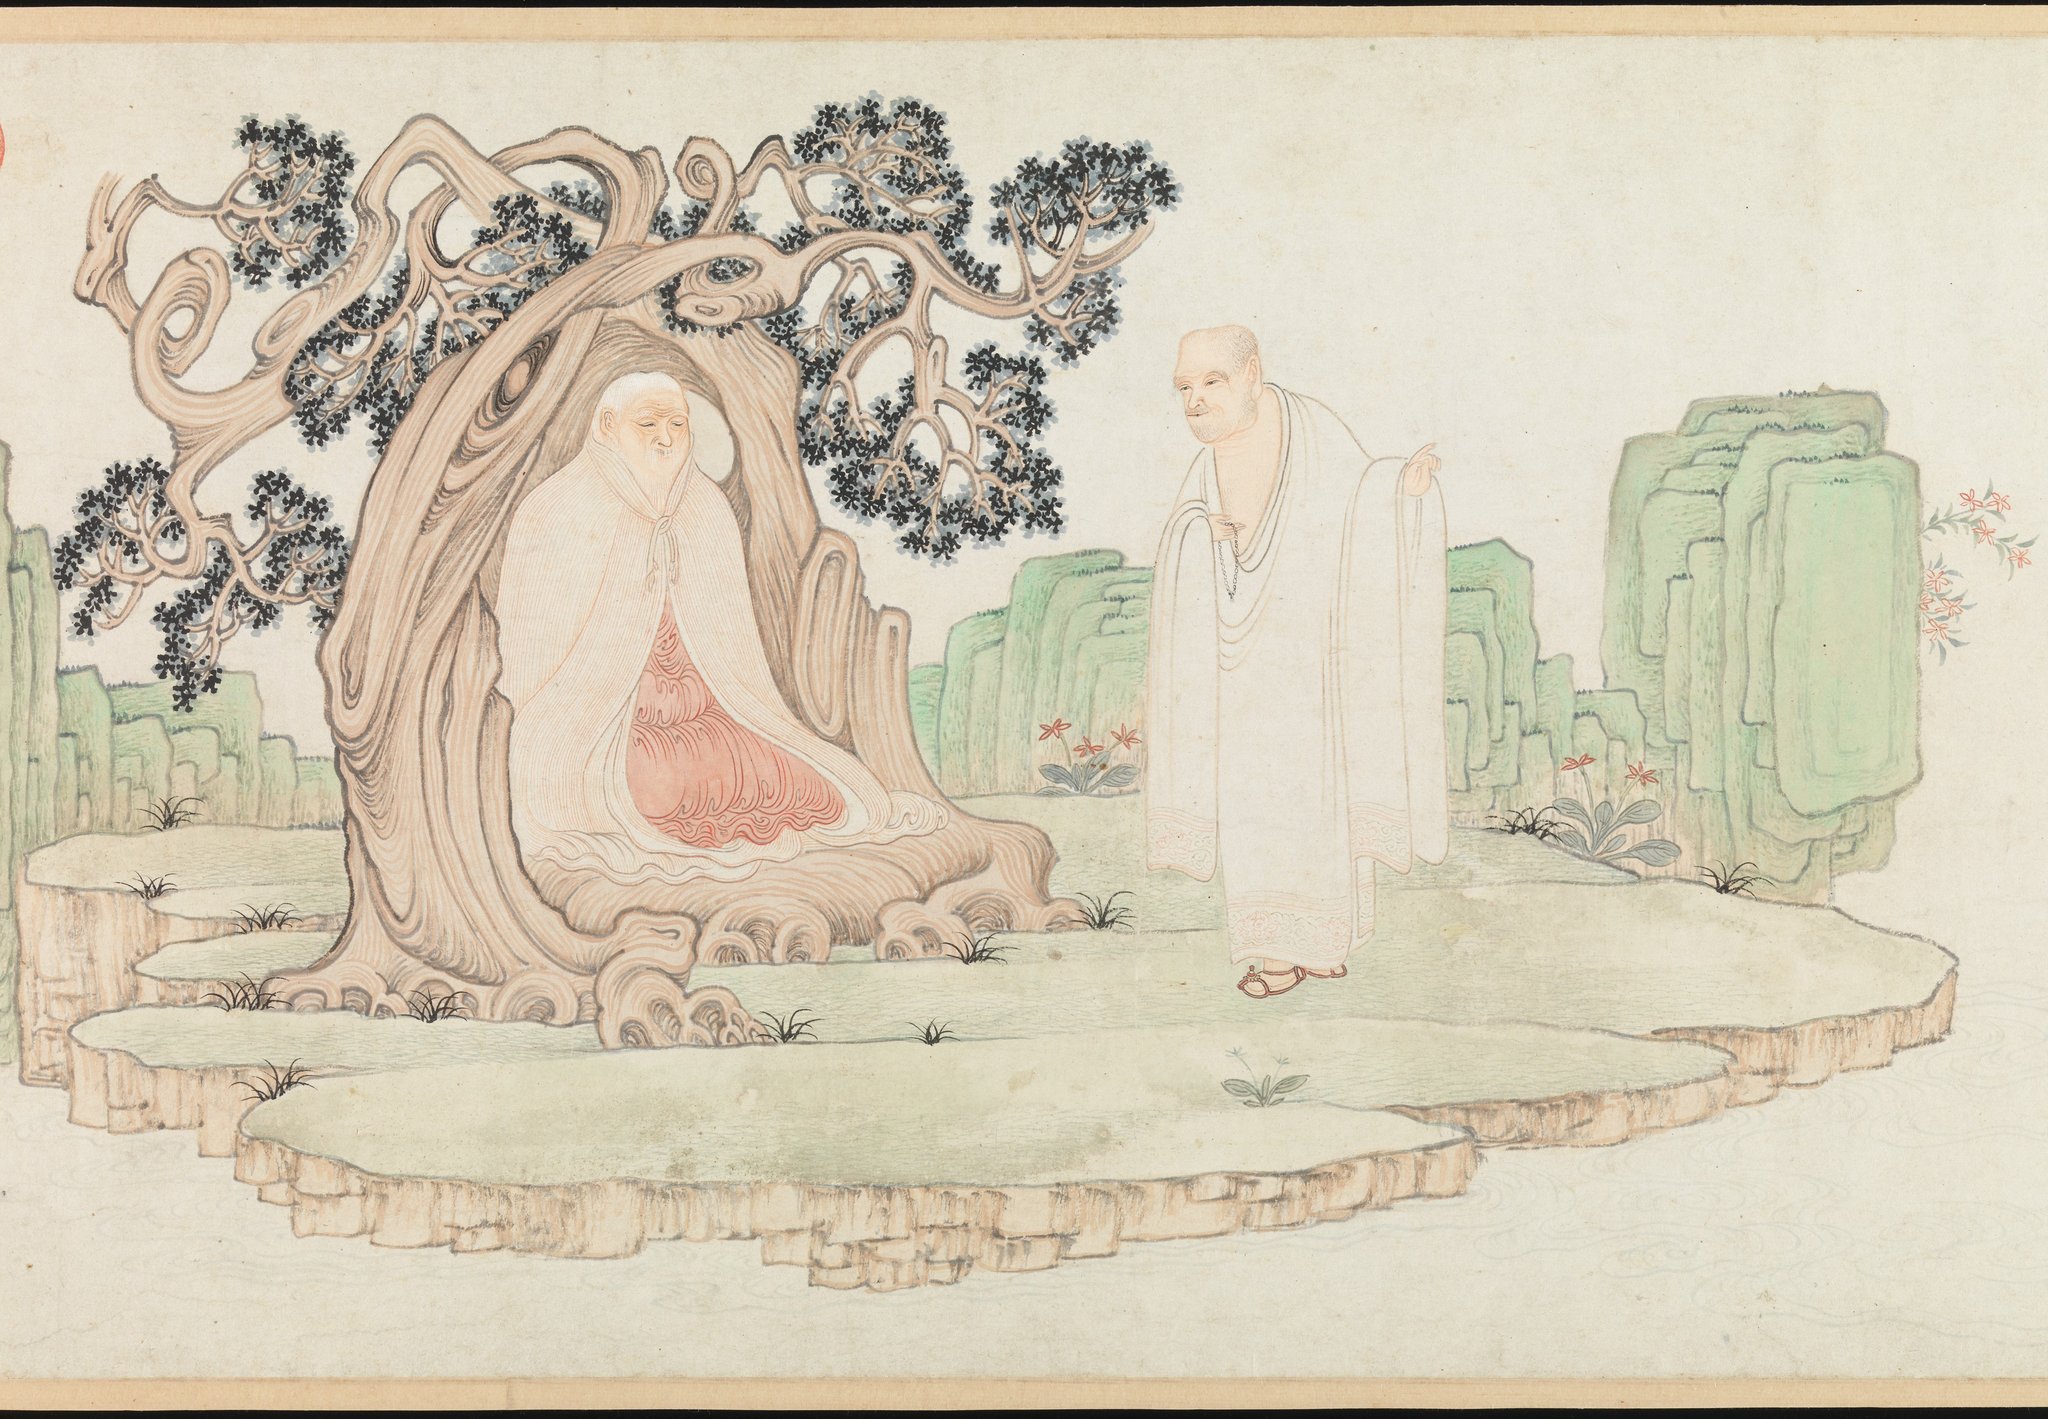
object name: handscroll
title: The Sixteen Luohans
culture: chinese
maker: wu bin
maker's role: artist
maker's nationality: chinese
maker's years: 1583-1626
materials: ink, paper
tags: men,buddhism